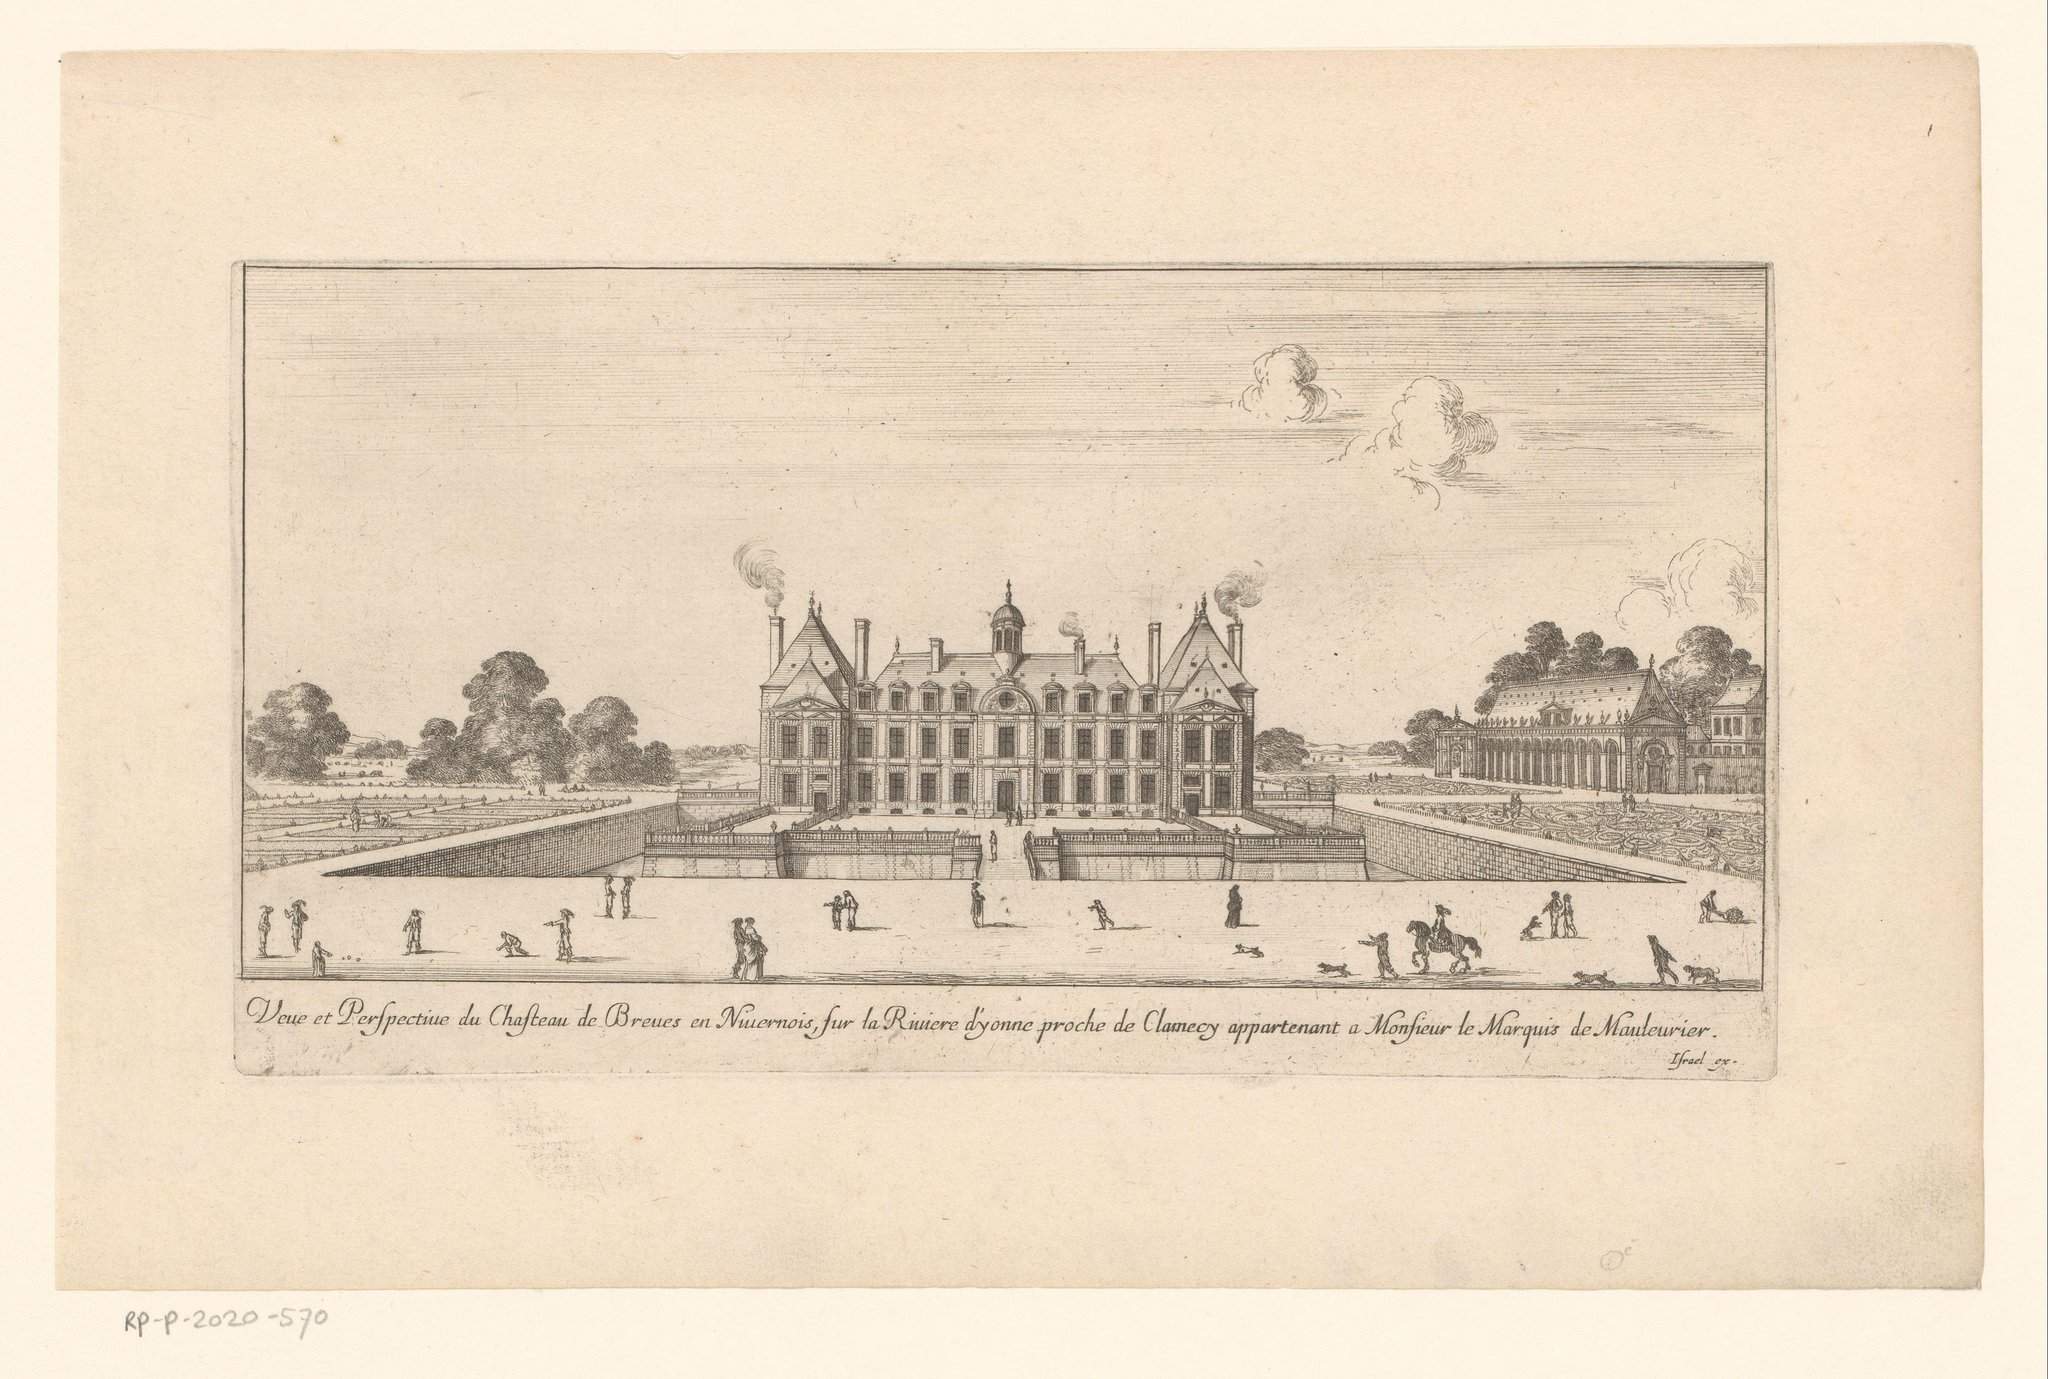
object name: print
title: Veue et Perspective du Chasteau de Breves en Nivernois, sur la Riviere d'yonne proche de Clamecy appartenant a Monsieur le Marquis de Maulevrier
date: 1651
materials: paper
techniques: etching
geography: paris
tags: castle, french or architectonic garden; formal garden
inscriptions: collector's mark: Lugt 2228